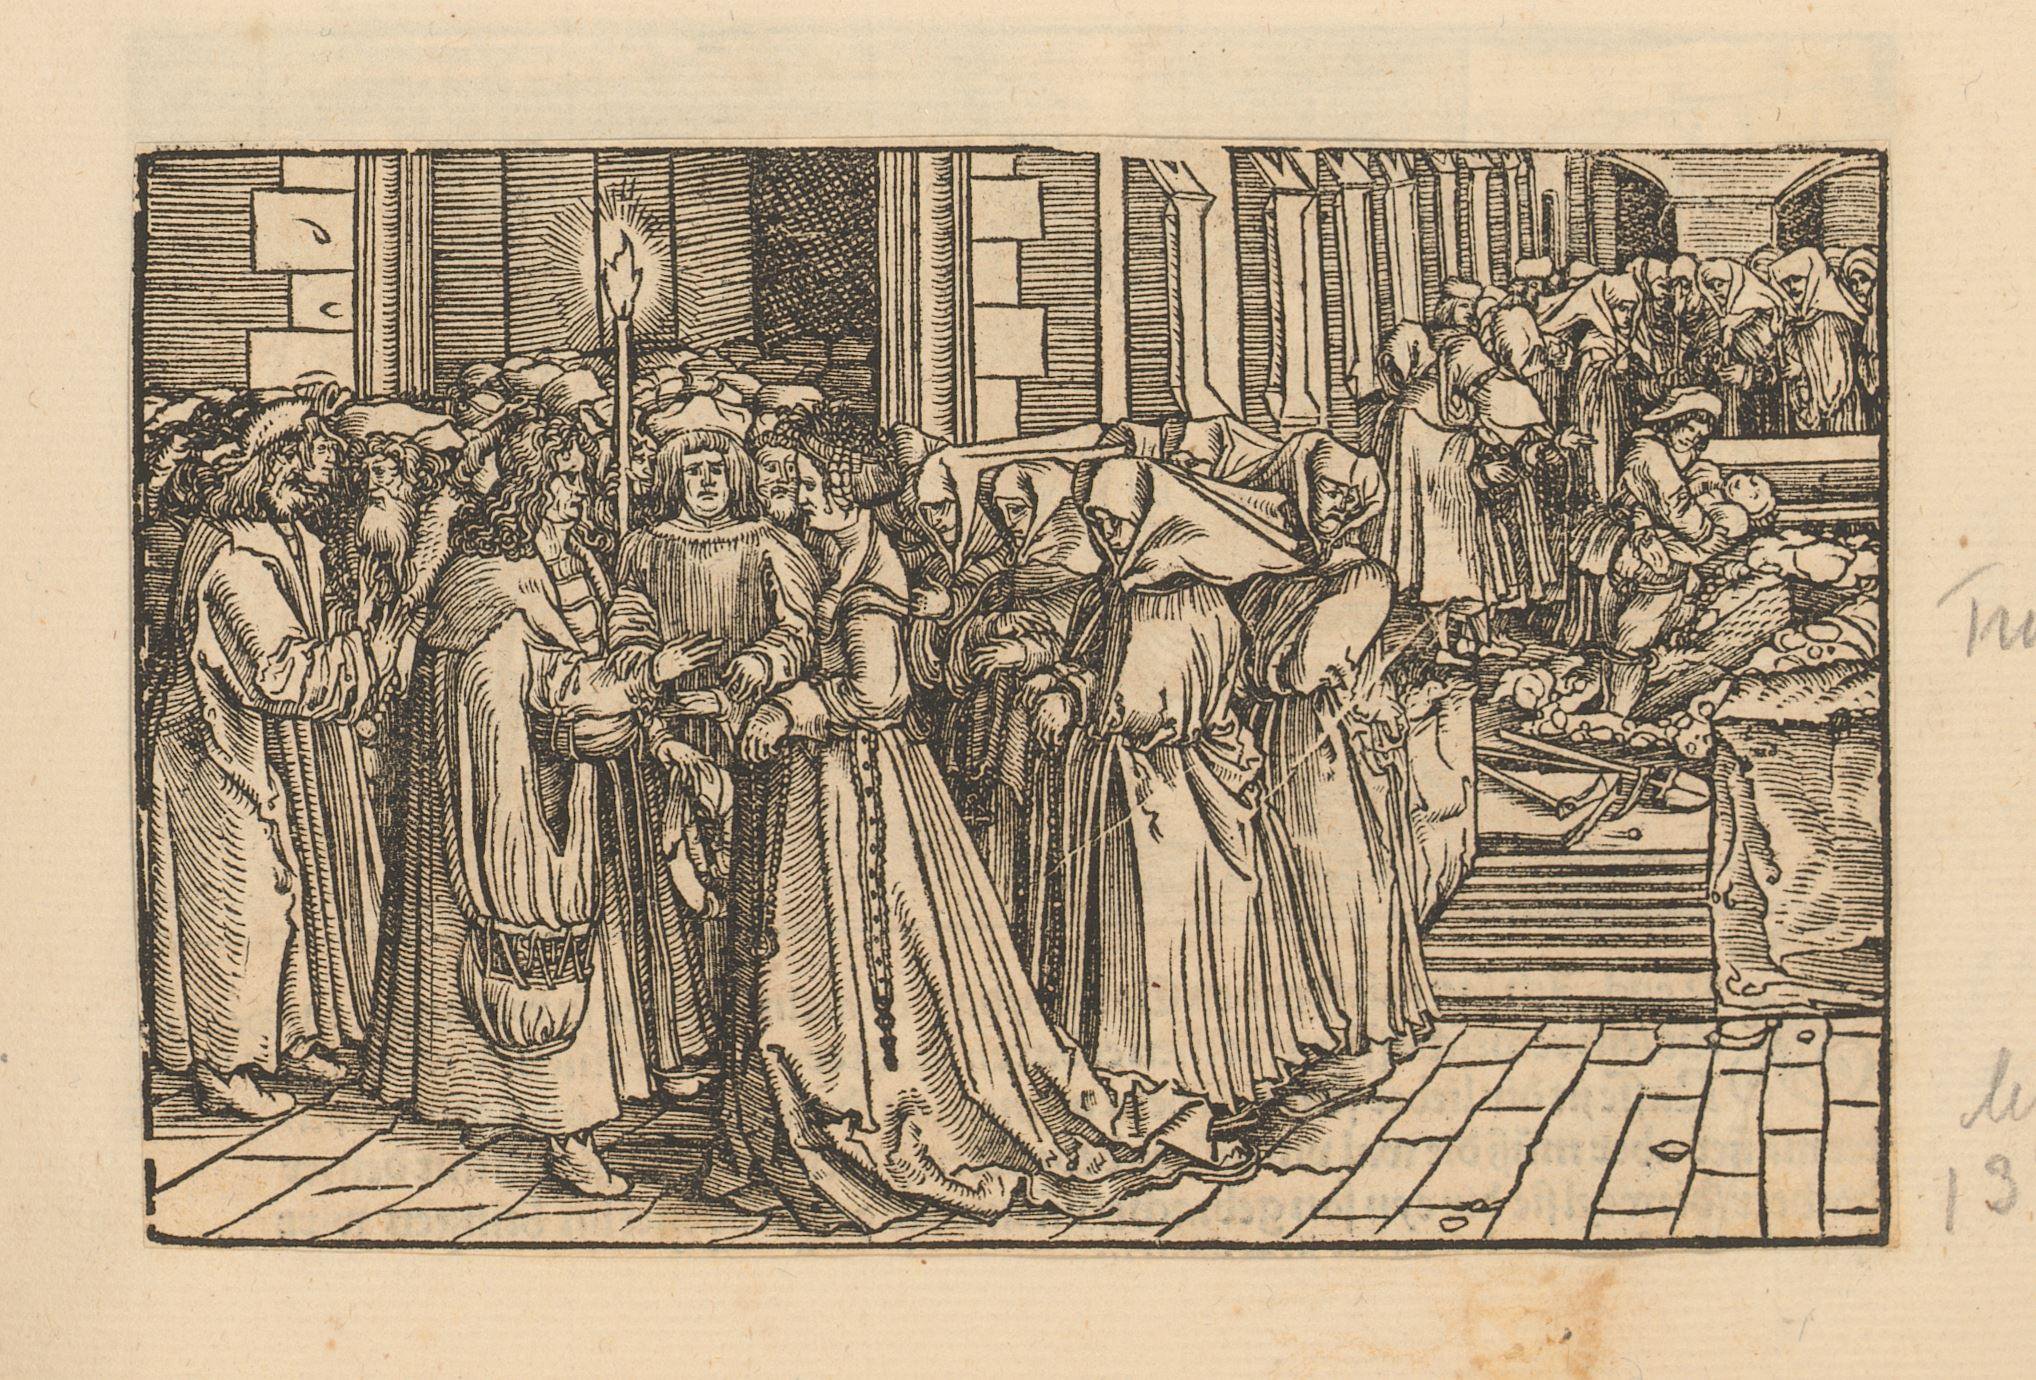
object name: print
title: Huwelijk van een man en zijn tweede vrouw terwijl zijn eerste vrouw wordt begraven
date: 1514-1532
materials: paper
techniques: letterpress printing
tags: second marriage (of widow or widower), marriage, married couple, 'matrimonium'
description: Deze prent is gebruikt in: Petrarca, Francesco. Von der Artzney bayder Glück, des guten und widerwertigen: unnd weß sich ain yeder inn Gelück und Unglück halten sol (...). Augsburg: Heinrich Steiner, 1532. Deze uitgave is ook bekend onder de titel 'Trostspiegel in Glück und Unglück'. Deze prent is ook gebruikt in: Cicero, Marcus Tulius. Officia M.T.C. Ein Buch so Marcus Tullius Cicero der Römer zu seynem (...). [Vertaald uit het Latijn door] Johann von Schwarzenberg. Augsburg: Heinrich Steiner, 1531.